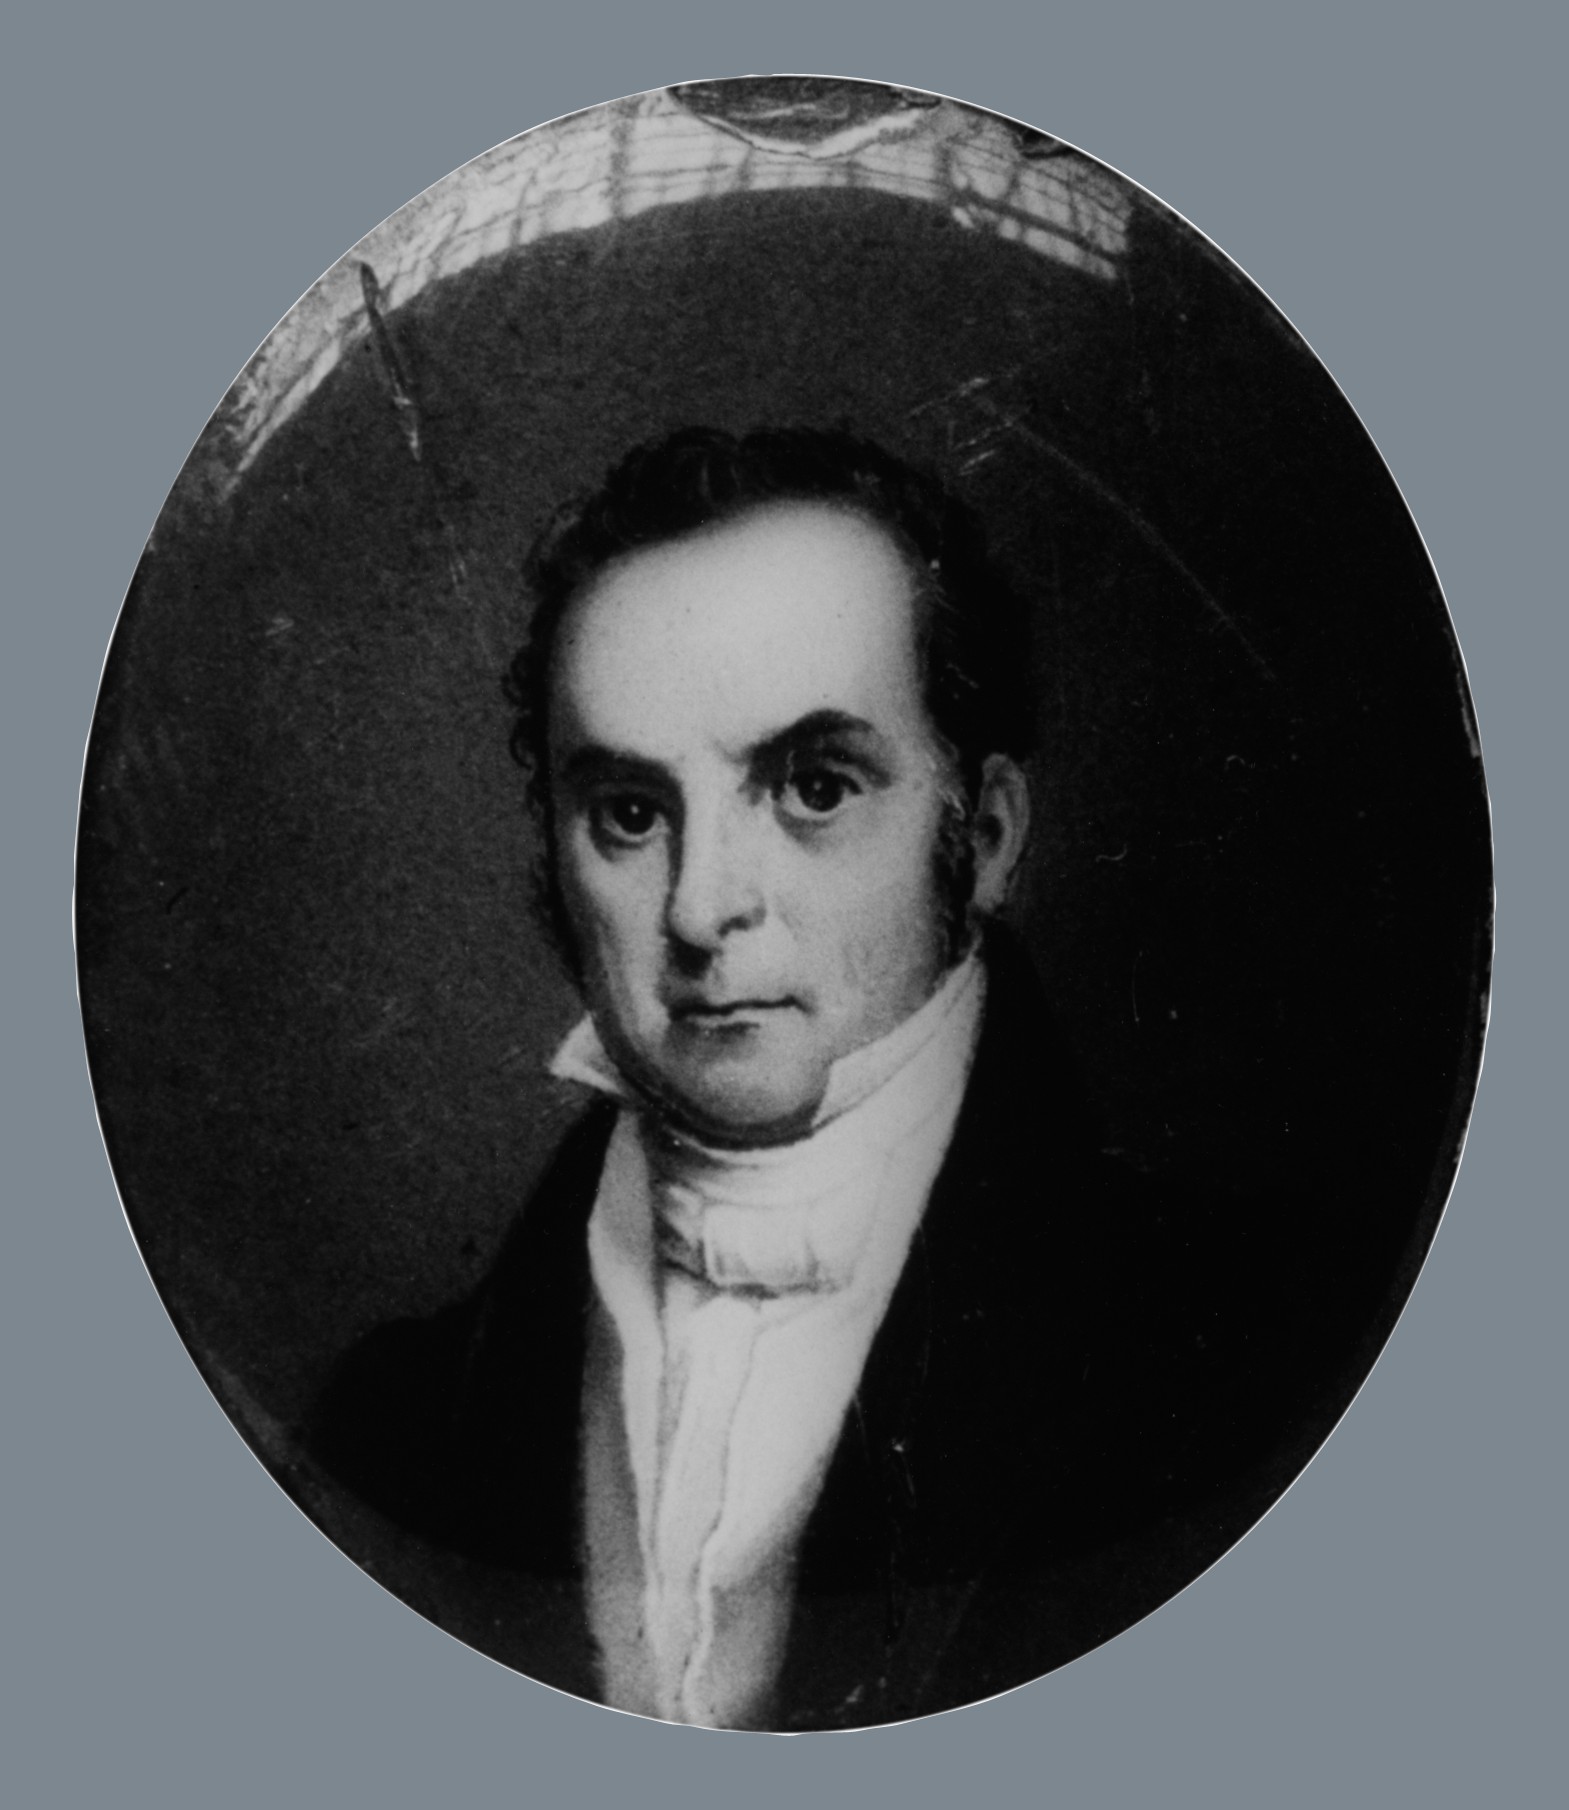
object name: painting, miniature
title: Daniel Webster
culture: american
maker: william russell birch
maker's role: artist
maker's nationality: american, born england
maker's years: 1755-1834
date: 1833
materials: copper, enamel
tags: men,portraits